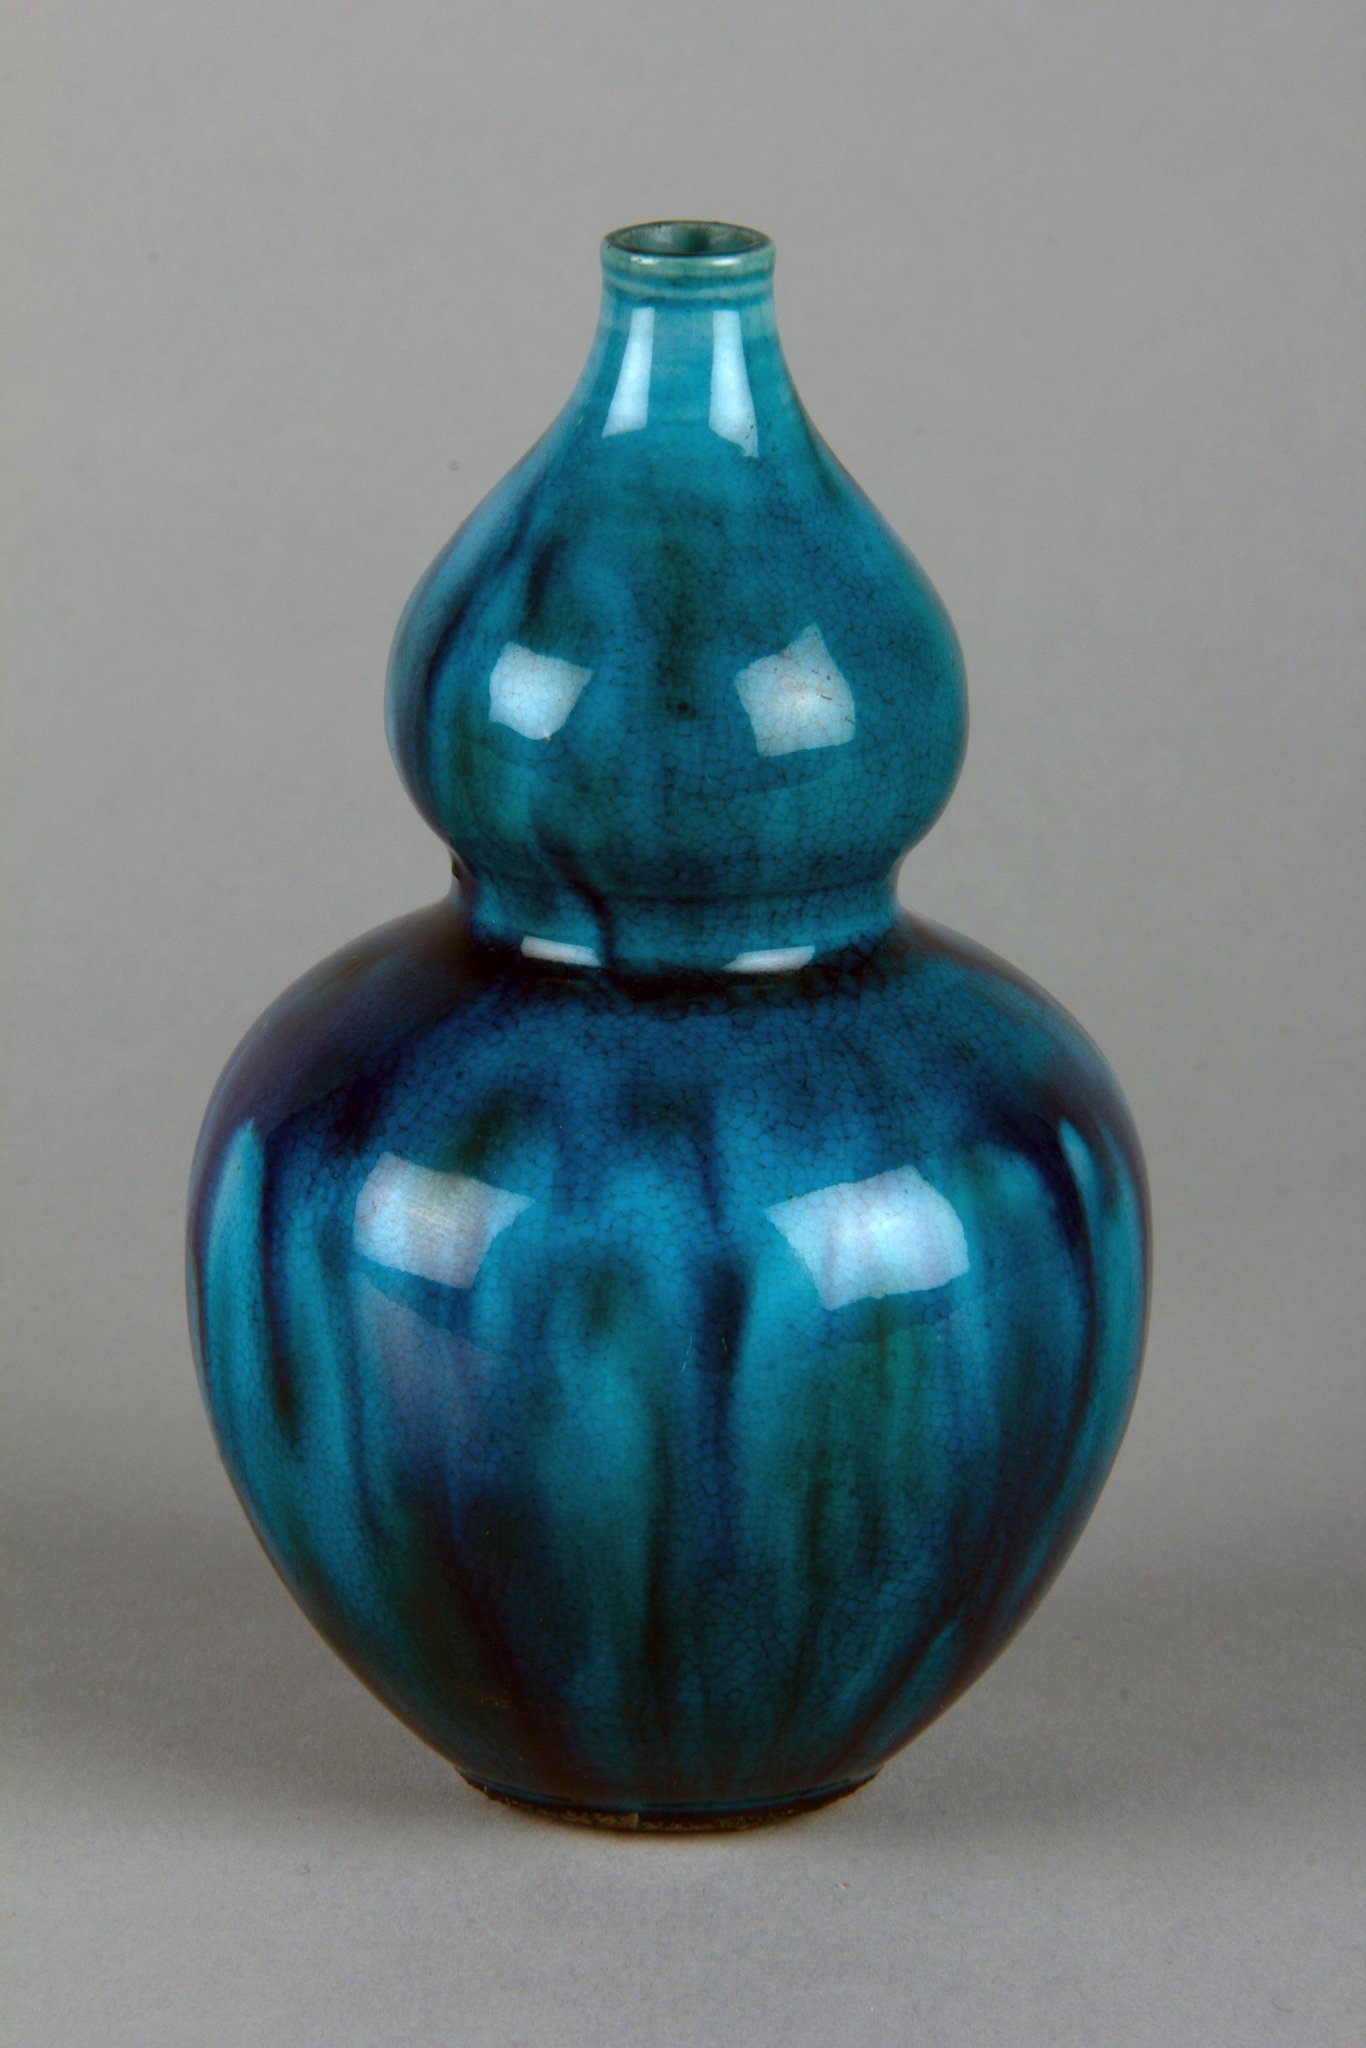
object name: bottle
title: Double gourd bottle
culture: chinese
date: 1801-1900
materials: glaze, porcelain